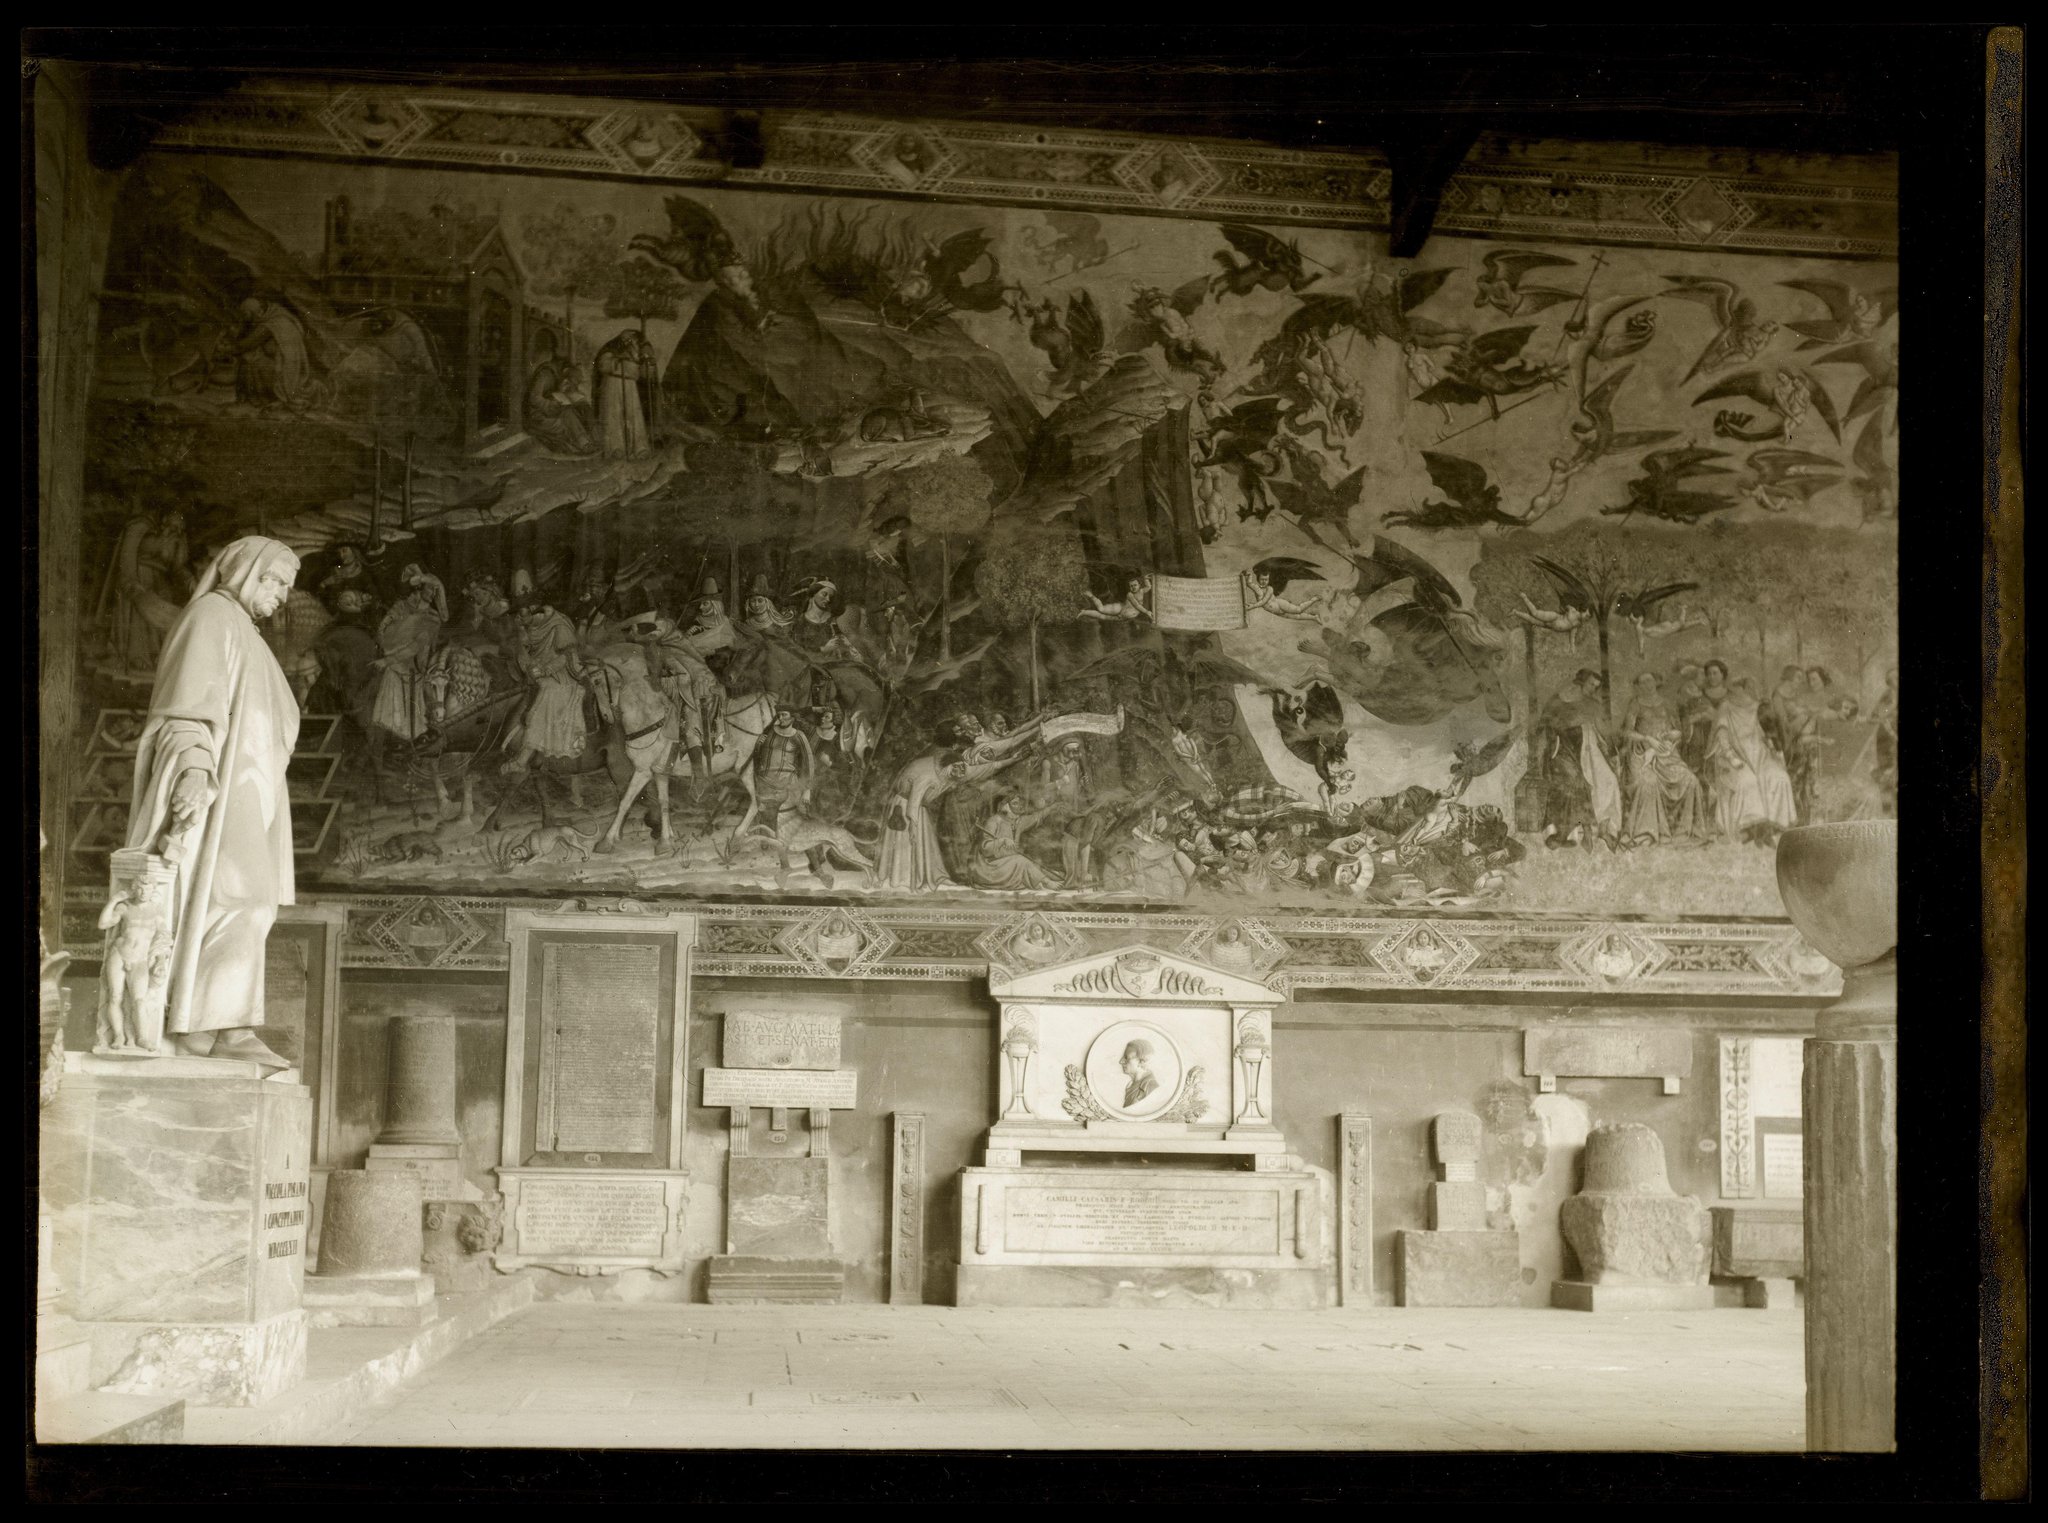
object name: photograph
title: Filmnegatief met opname van Genua, Pisa, Ravenna of Milaan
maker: Anonymous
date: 1907-1935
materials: film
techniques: gelatin silver negative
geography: italy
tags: italy